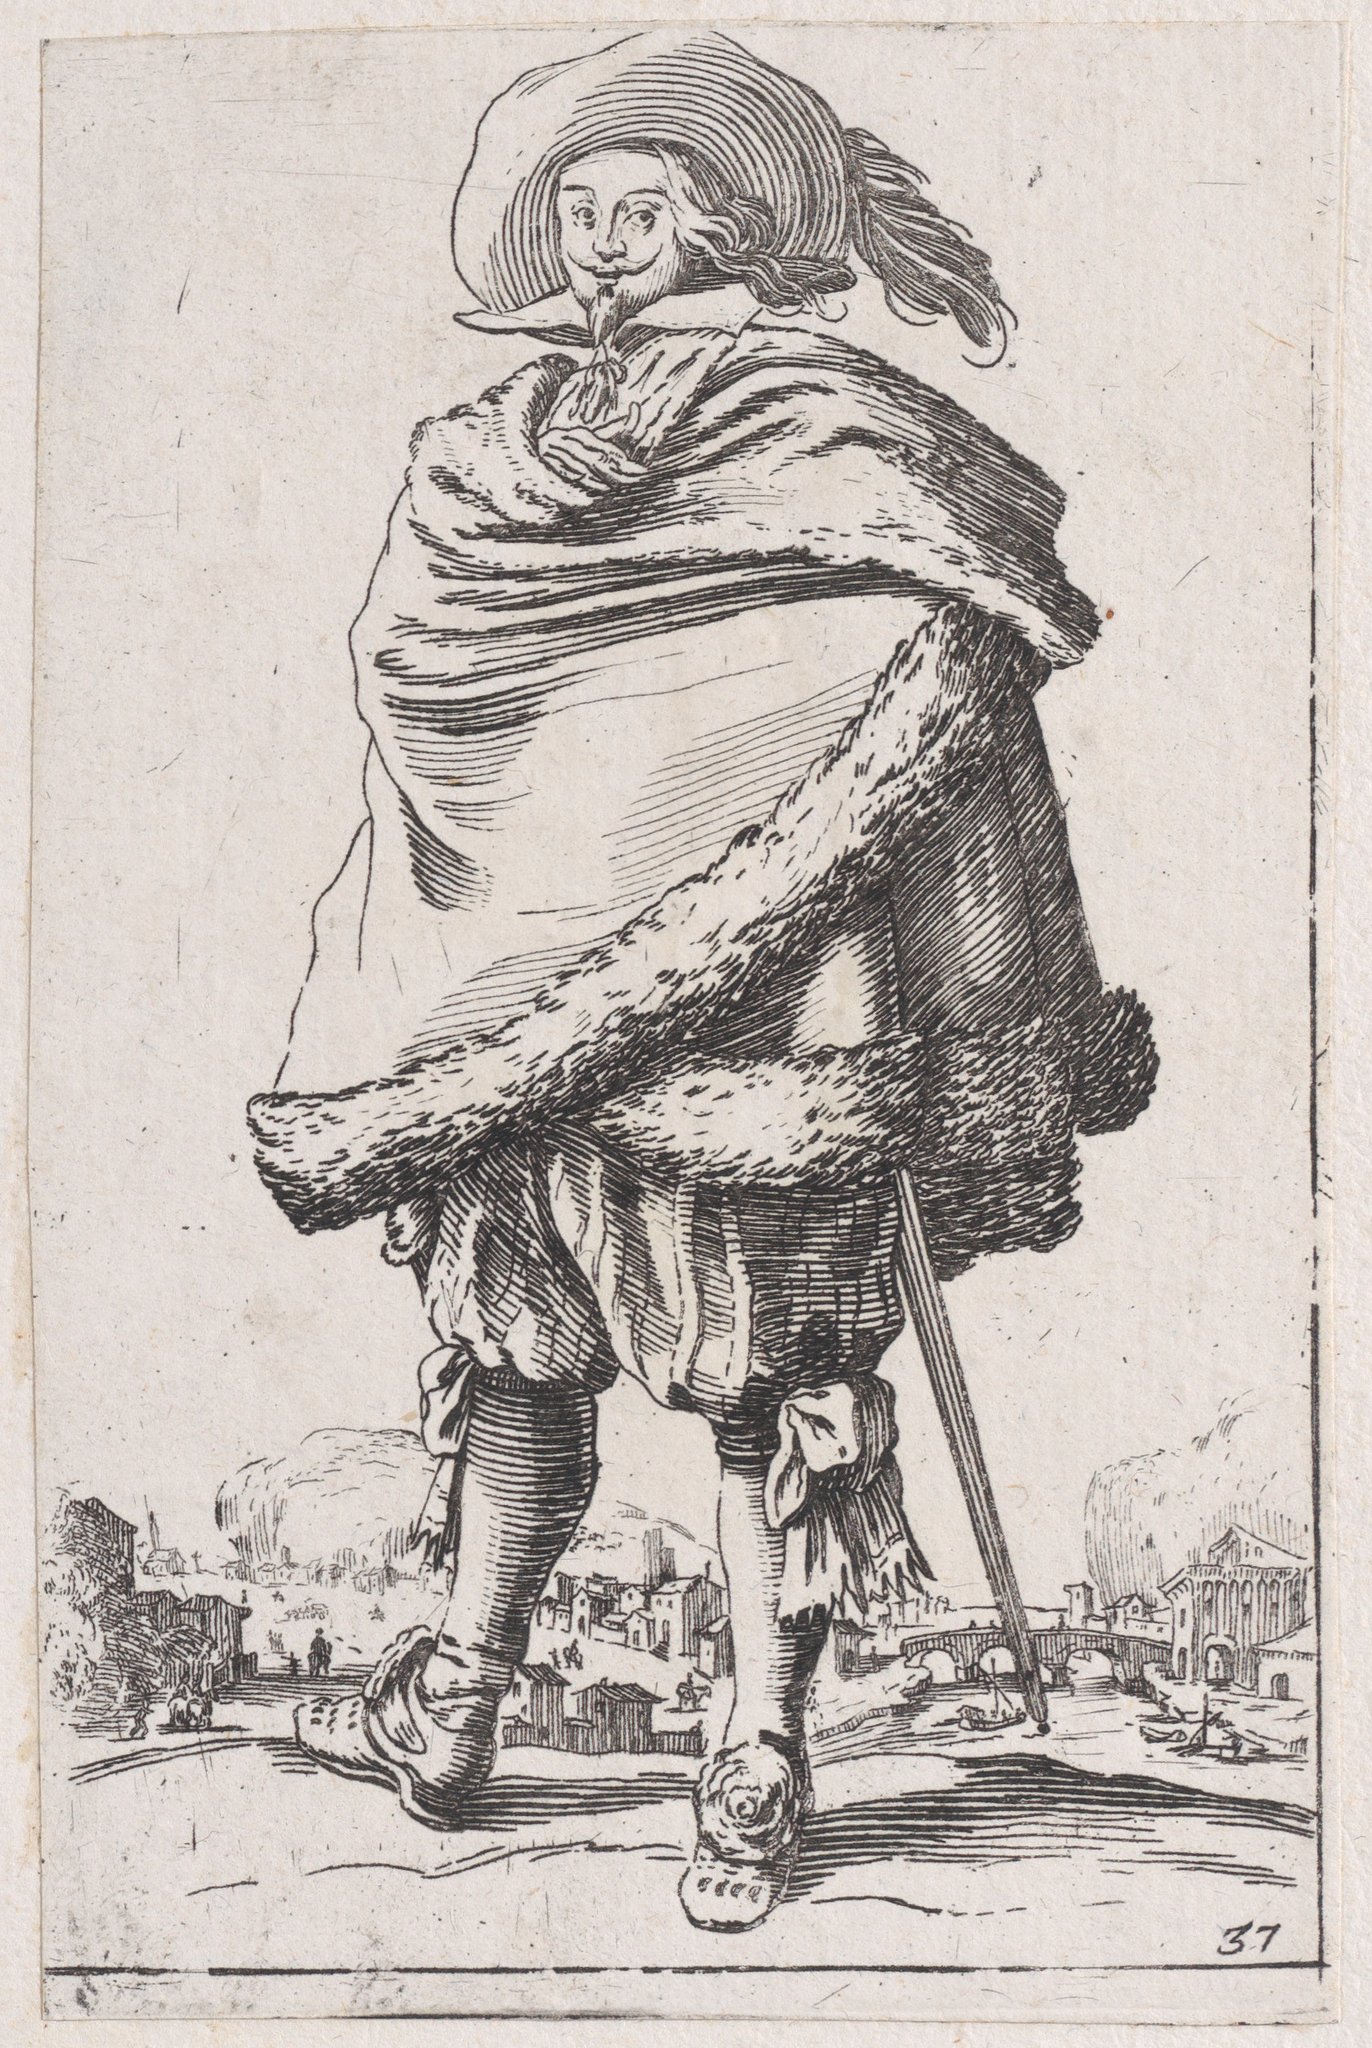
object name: print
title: Reverse Copy of La Mendiante Venant de Recevoir la Charité (The Female Beggar Receiving her Charity), from Les Gueux suite appelée aussi Les Mendiants, Les Baroni, ou Les Barons (The Beggars, also called the Barons)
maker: Anonymous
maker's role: artist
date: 1601-1700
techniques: etching